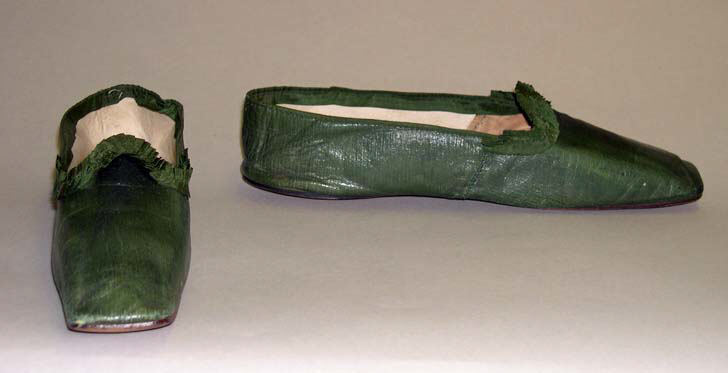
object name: slipper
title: Slippers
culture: french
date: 1840-1849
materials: leather